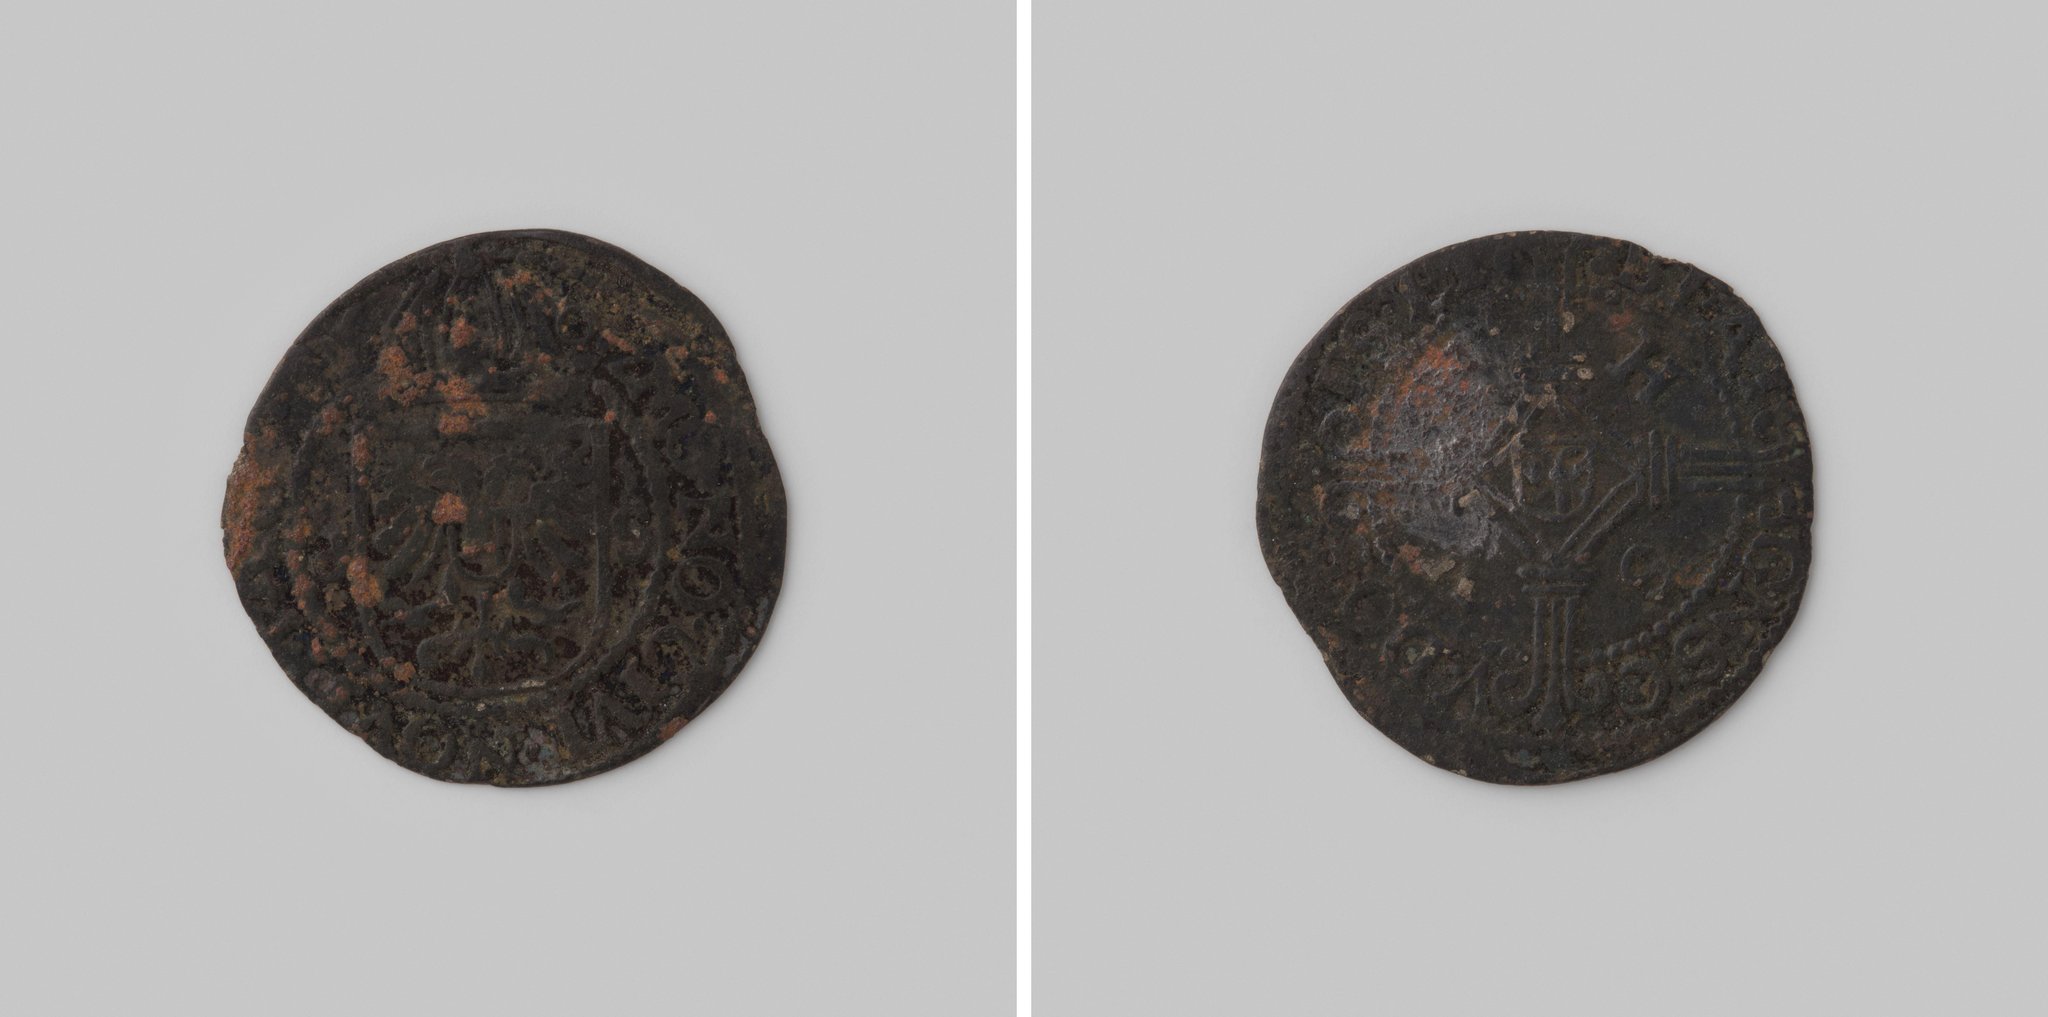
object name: coin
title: Nijmeegse halve stuiver, 1620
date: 1620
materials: silver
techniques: striking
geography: nijmegen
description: Koper-zilveren munt. Voorzijde: tussen waarde-aanduiding 1/2 S gekroond wapenschild van Nijmegen. Rondom kroon jaartal. Keerzijde: lang versierd kruis, in hart stadswapenschildje, in hoeken letters H,S,V en N.